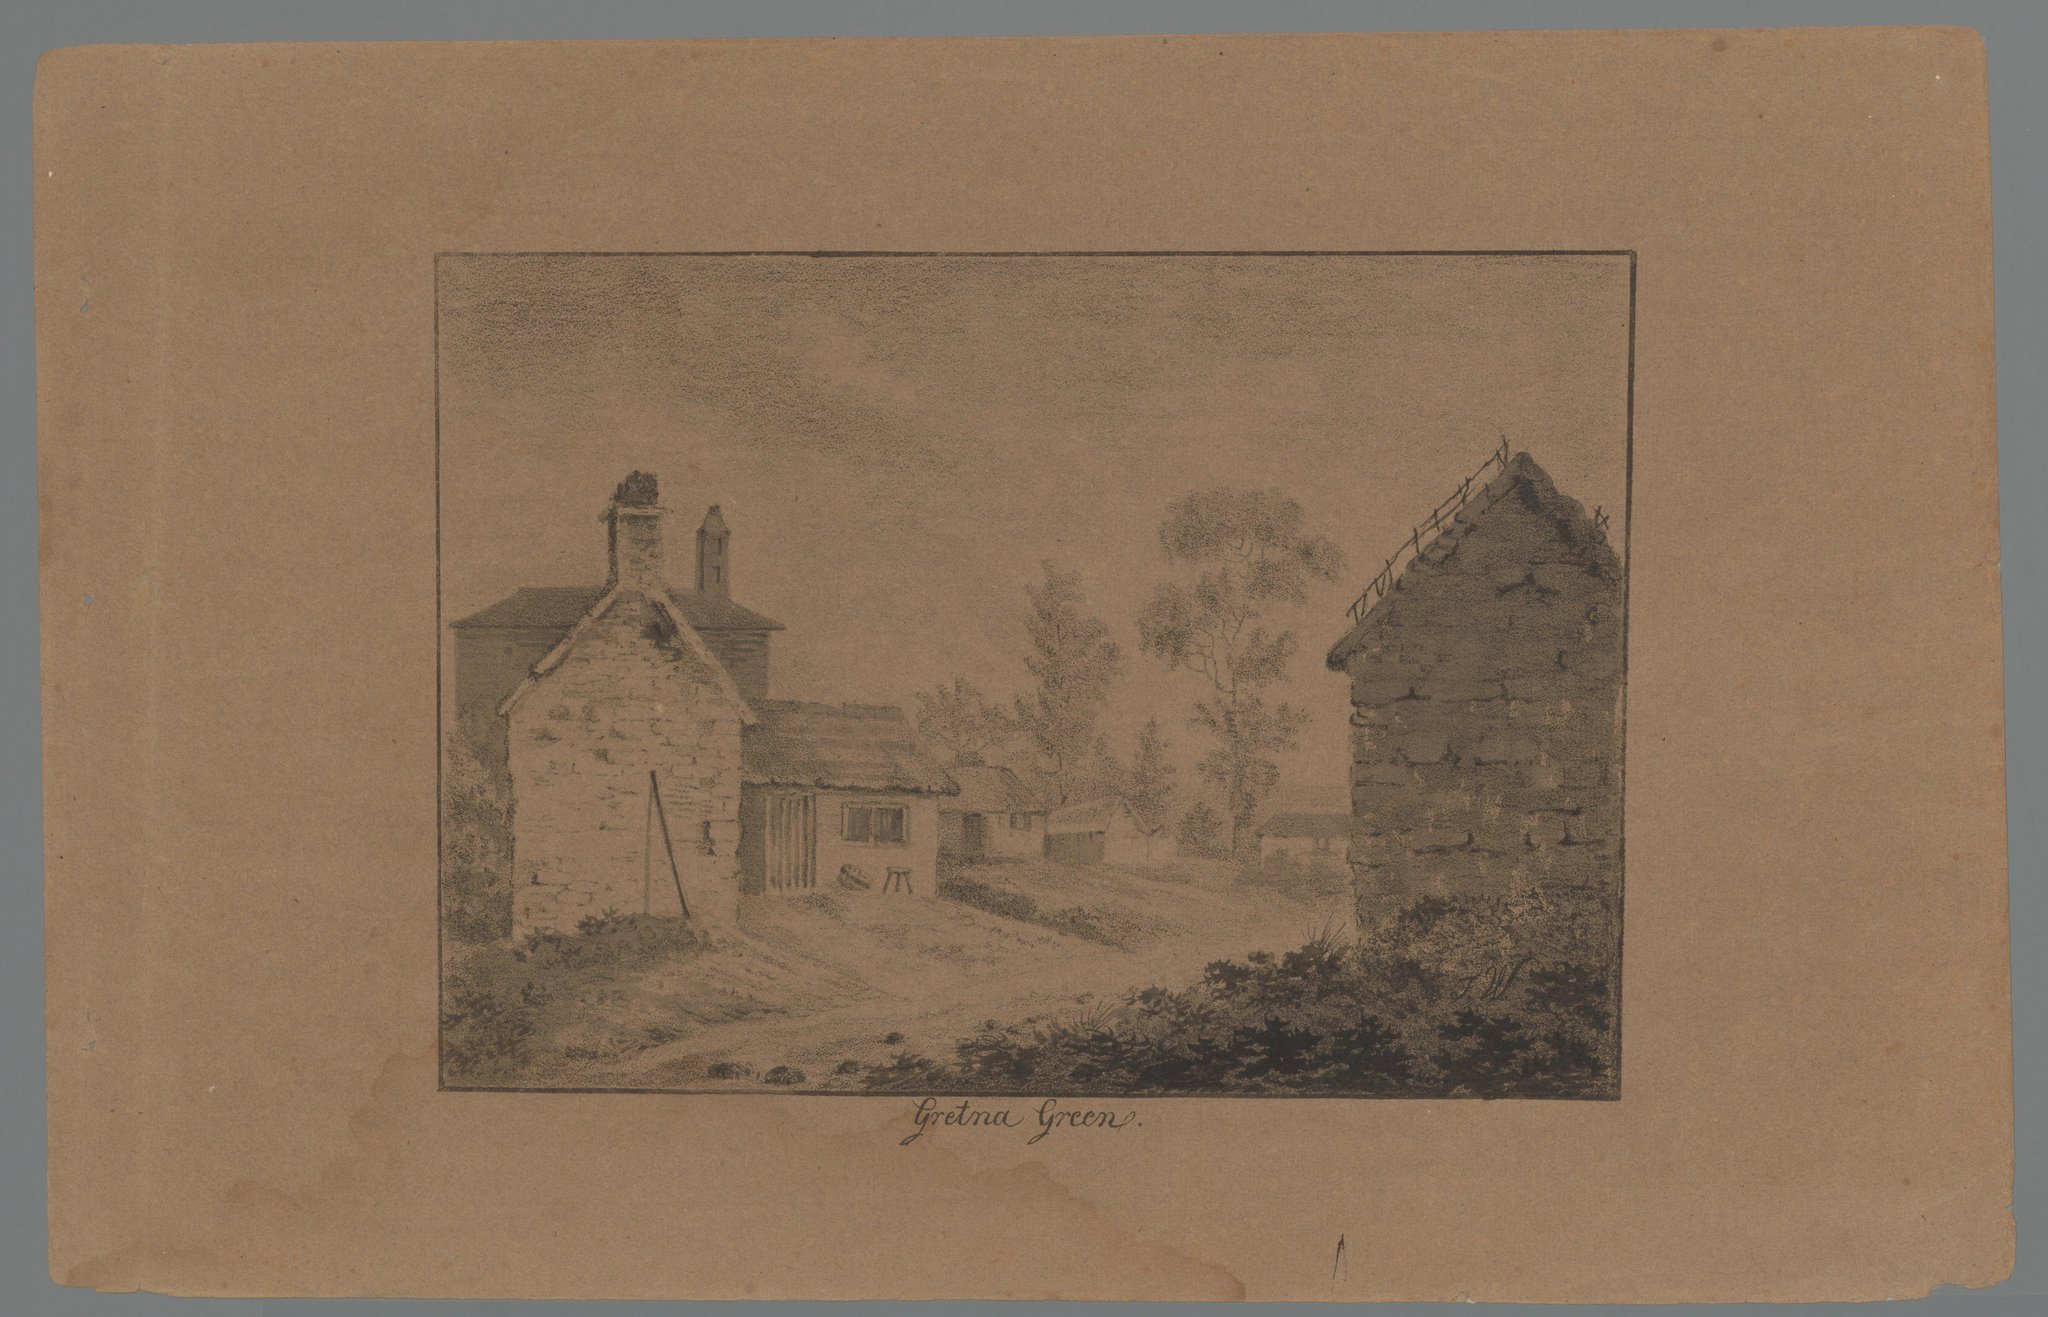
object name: print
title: Gezicht op Gretna Green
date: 1803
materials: ink, paper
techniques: brush, lithograph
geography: london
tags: village street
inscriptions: collector's mark: Lugt 2233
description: Deze prent behoort tot de serie 'Twelve views in Scotland, delineated by a lady in the polyautographic art of drawing on stone'. Deze serie met twaalf lithografieën is een van de vroegste reeksen lithografieën in Groot-Brittannië.